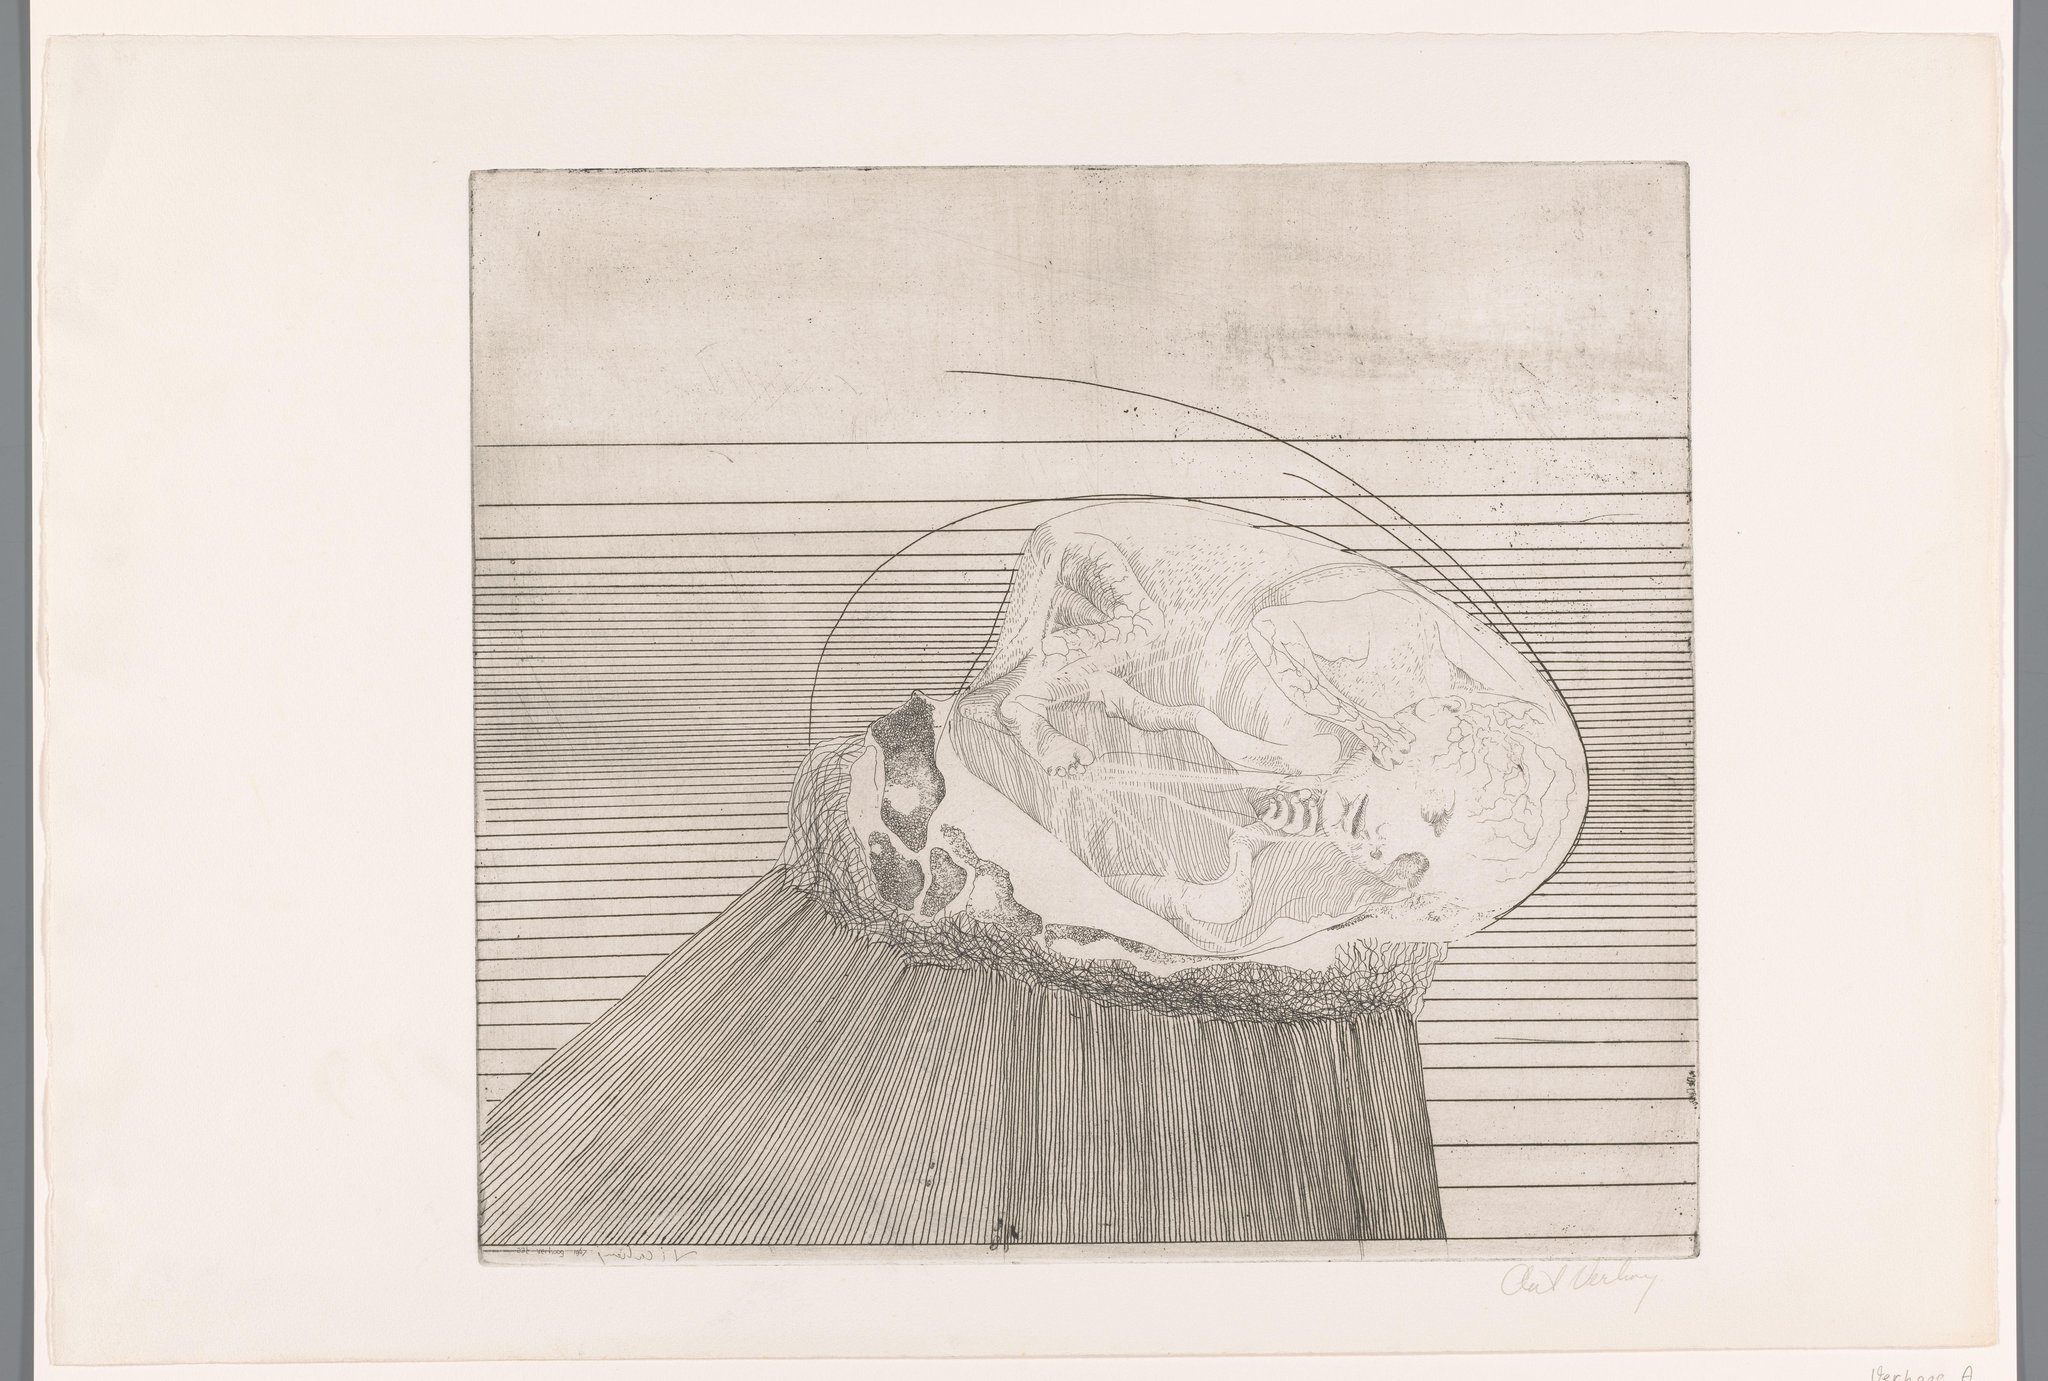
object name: print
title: Embryo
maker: aat verhoog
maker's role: print maker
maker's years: 1933-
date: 1967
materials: paper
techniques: etching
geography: amsterdam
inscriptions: signature and date: ‘Aat verhoog 1967’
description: Embryo tegen achtergrond van overwegend horizontale lijnen.